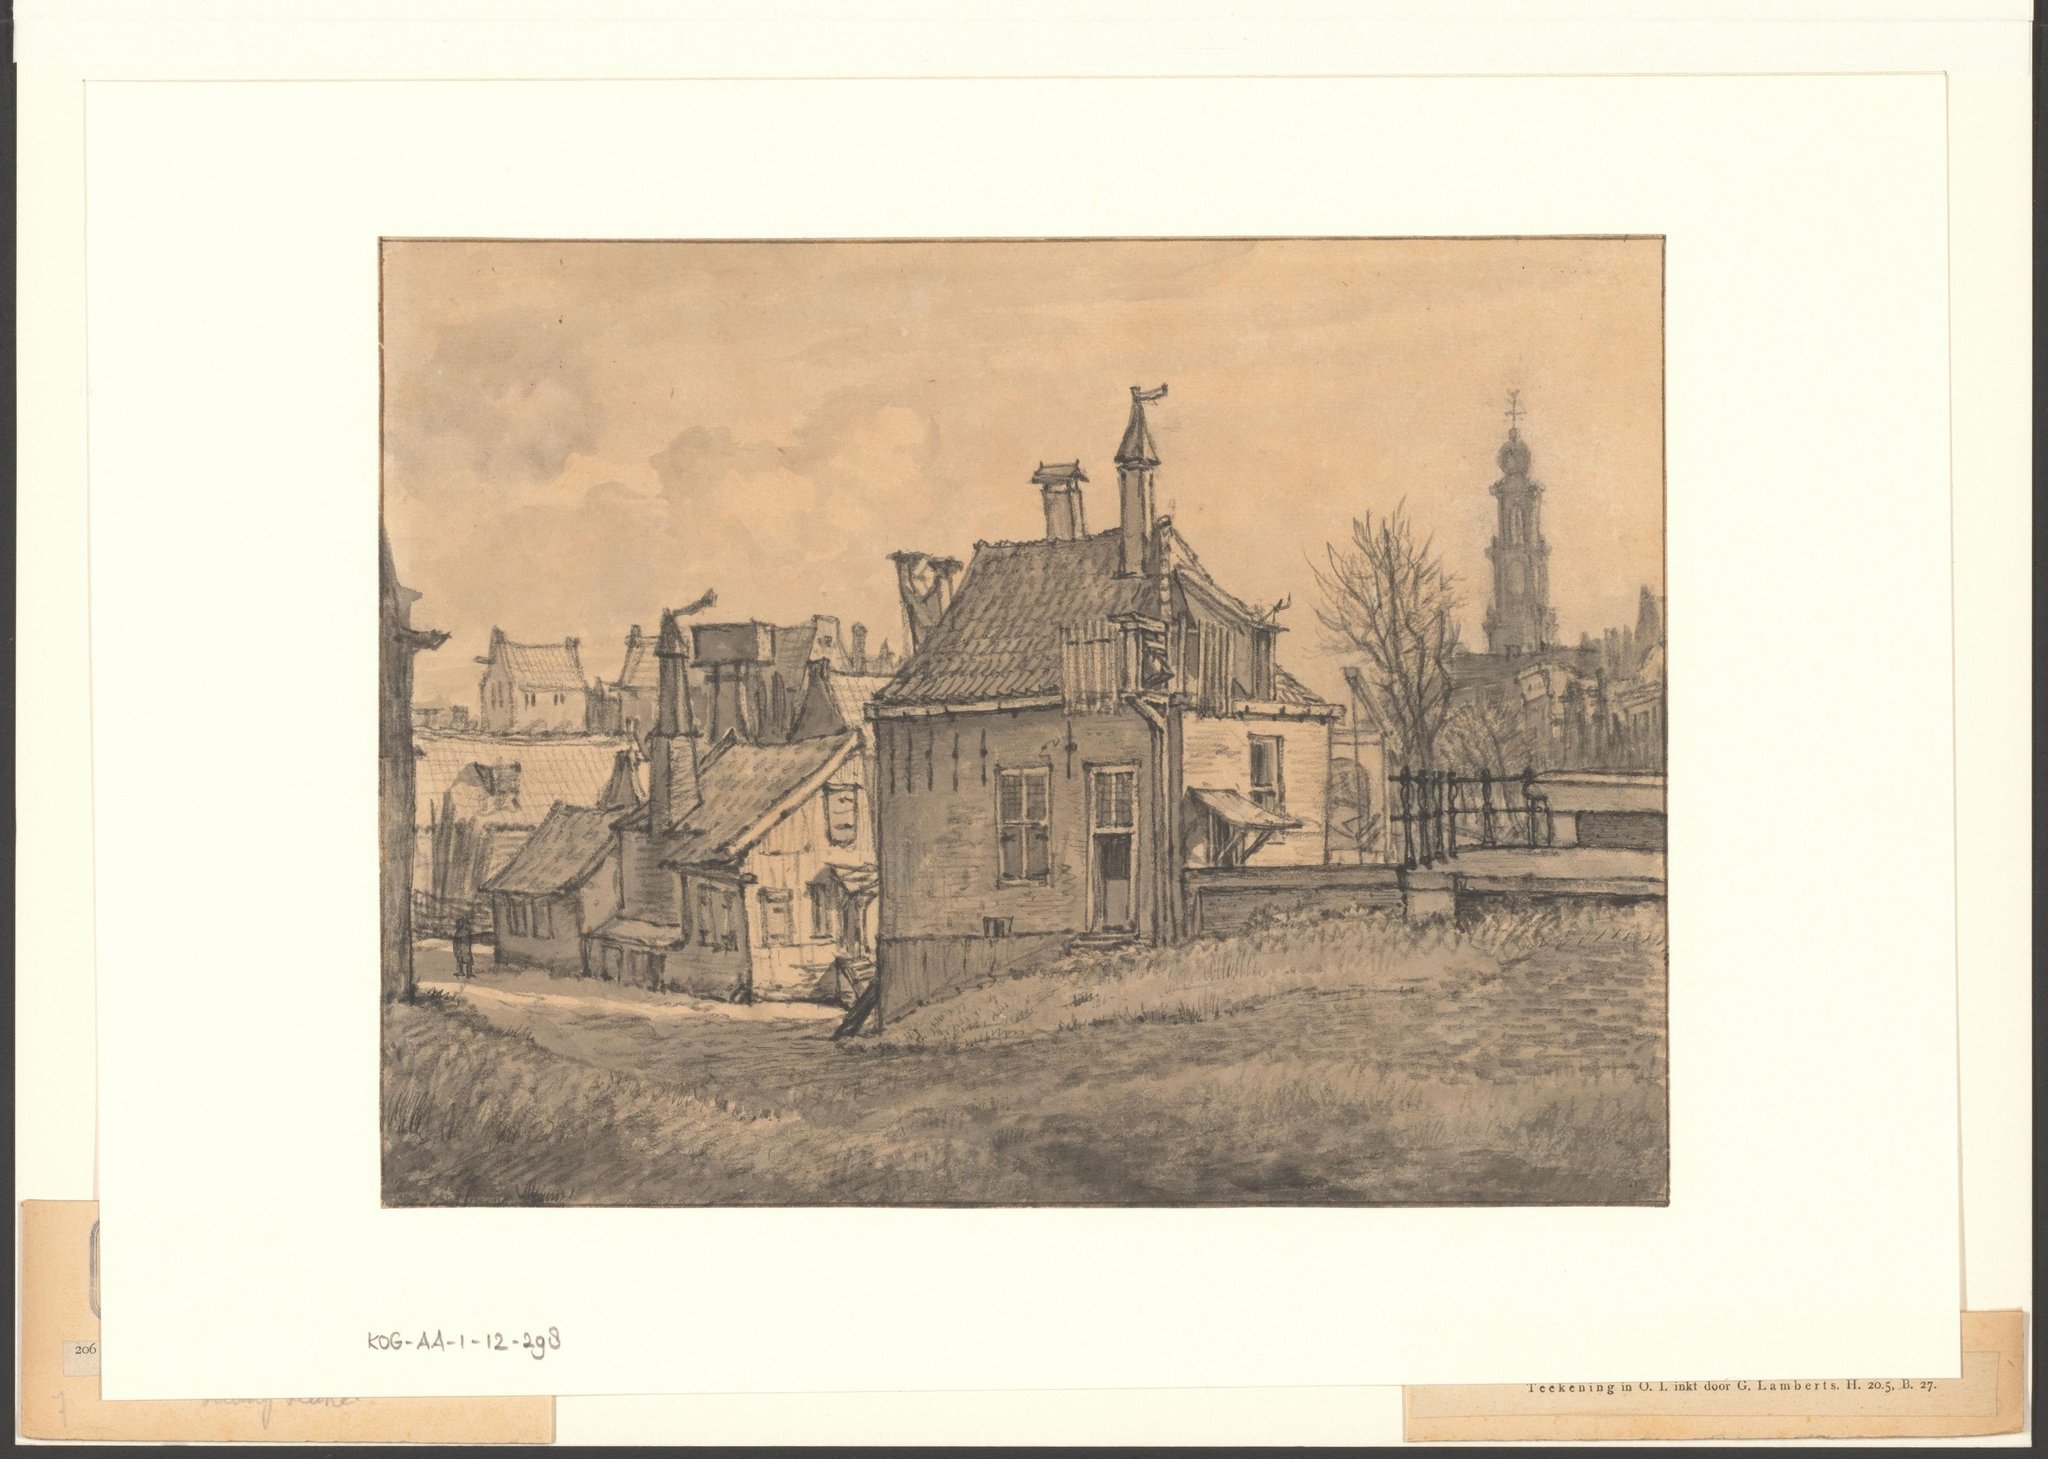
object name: drawing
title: Gezicht op enkele huizen en de Westertoren vanaf de Raampoort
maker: gerrit lamberts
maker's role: bookseller, draughtsman, print maker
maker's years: 1776-1850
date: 1817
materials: chalk, ink, paper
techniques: brush, pen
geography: amsterdam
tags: tower, clock tower ~ monumental adornment, city-view in general; 'veduta', the usual house or row of houses, street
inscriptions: collector's mark: ‘12’ Lugt 1641b, inscription: ‘Port. 12-298’, inscription: ‘206 Gezicht van (...) 20.5, B. 27.’, signature, date and inscription: ‘Gezigt van boven (...) G. Lamberts 1817.’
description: Onderwerpsrubriek binnen de Atlas Amsterdam: Rokin, Rotterdammersloot, Rozengang, Rozengracht, Rozenstraat, Rusland, Rustenburgerstraat, Ruysdaelkade, Ruysdaelstraat, Ruyterkade (de), Ruyterweg (Admiraal de).